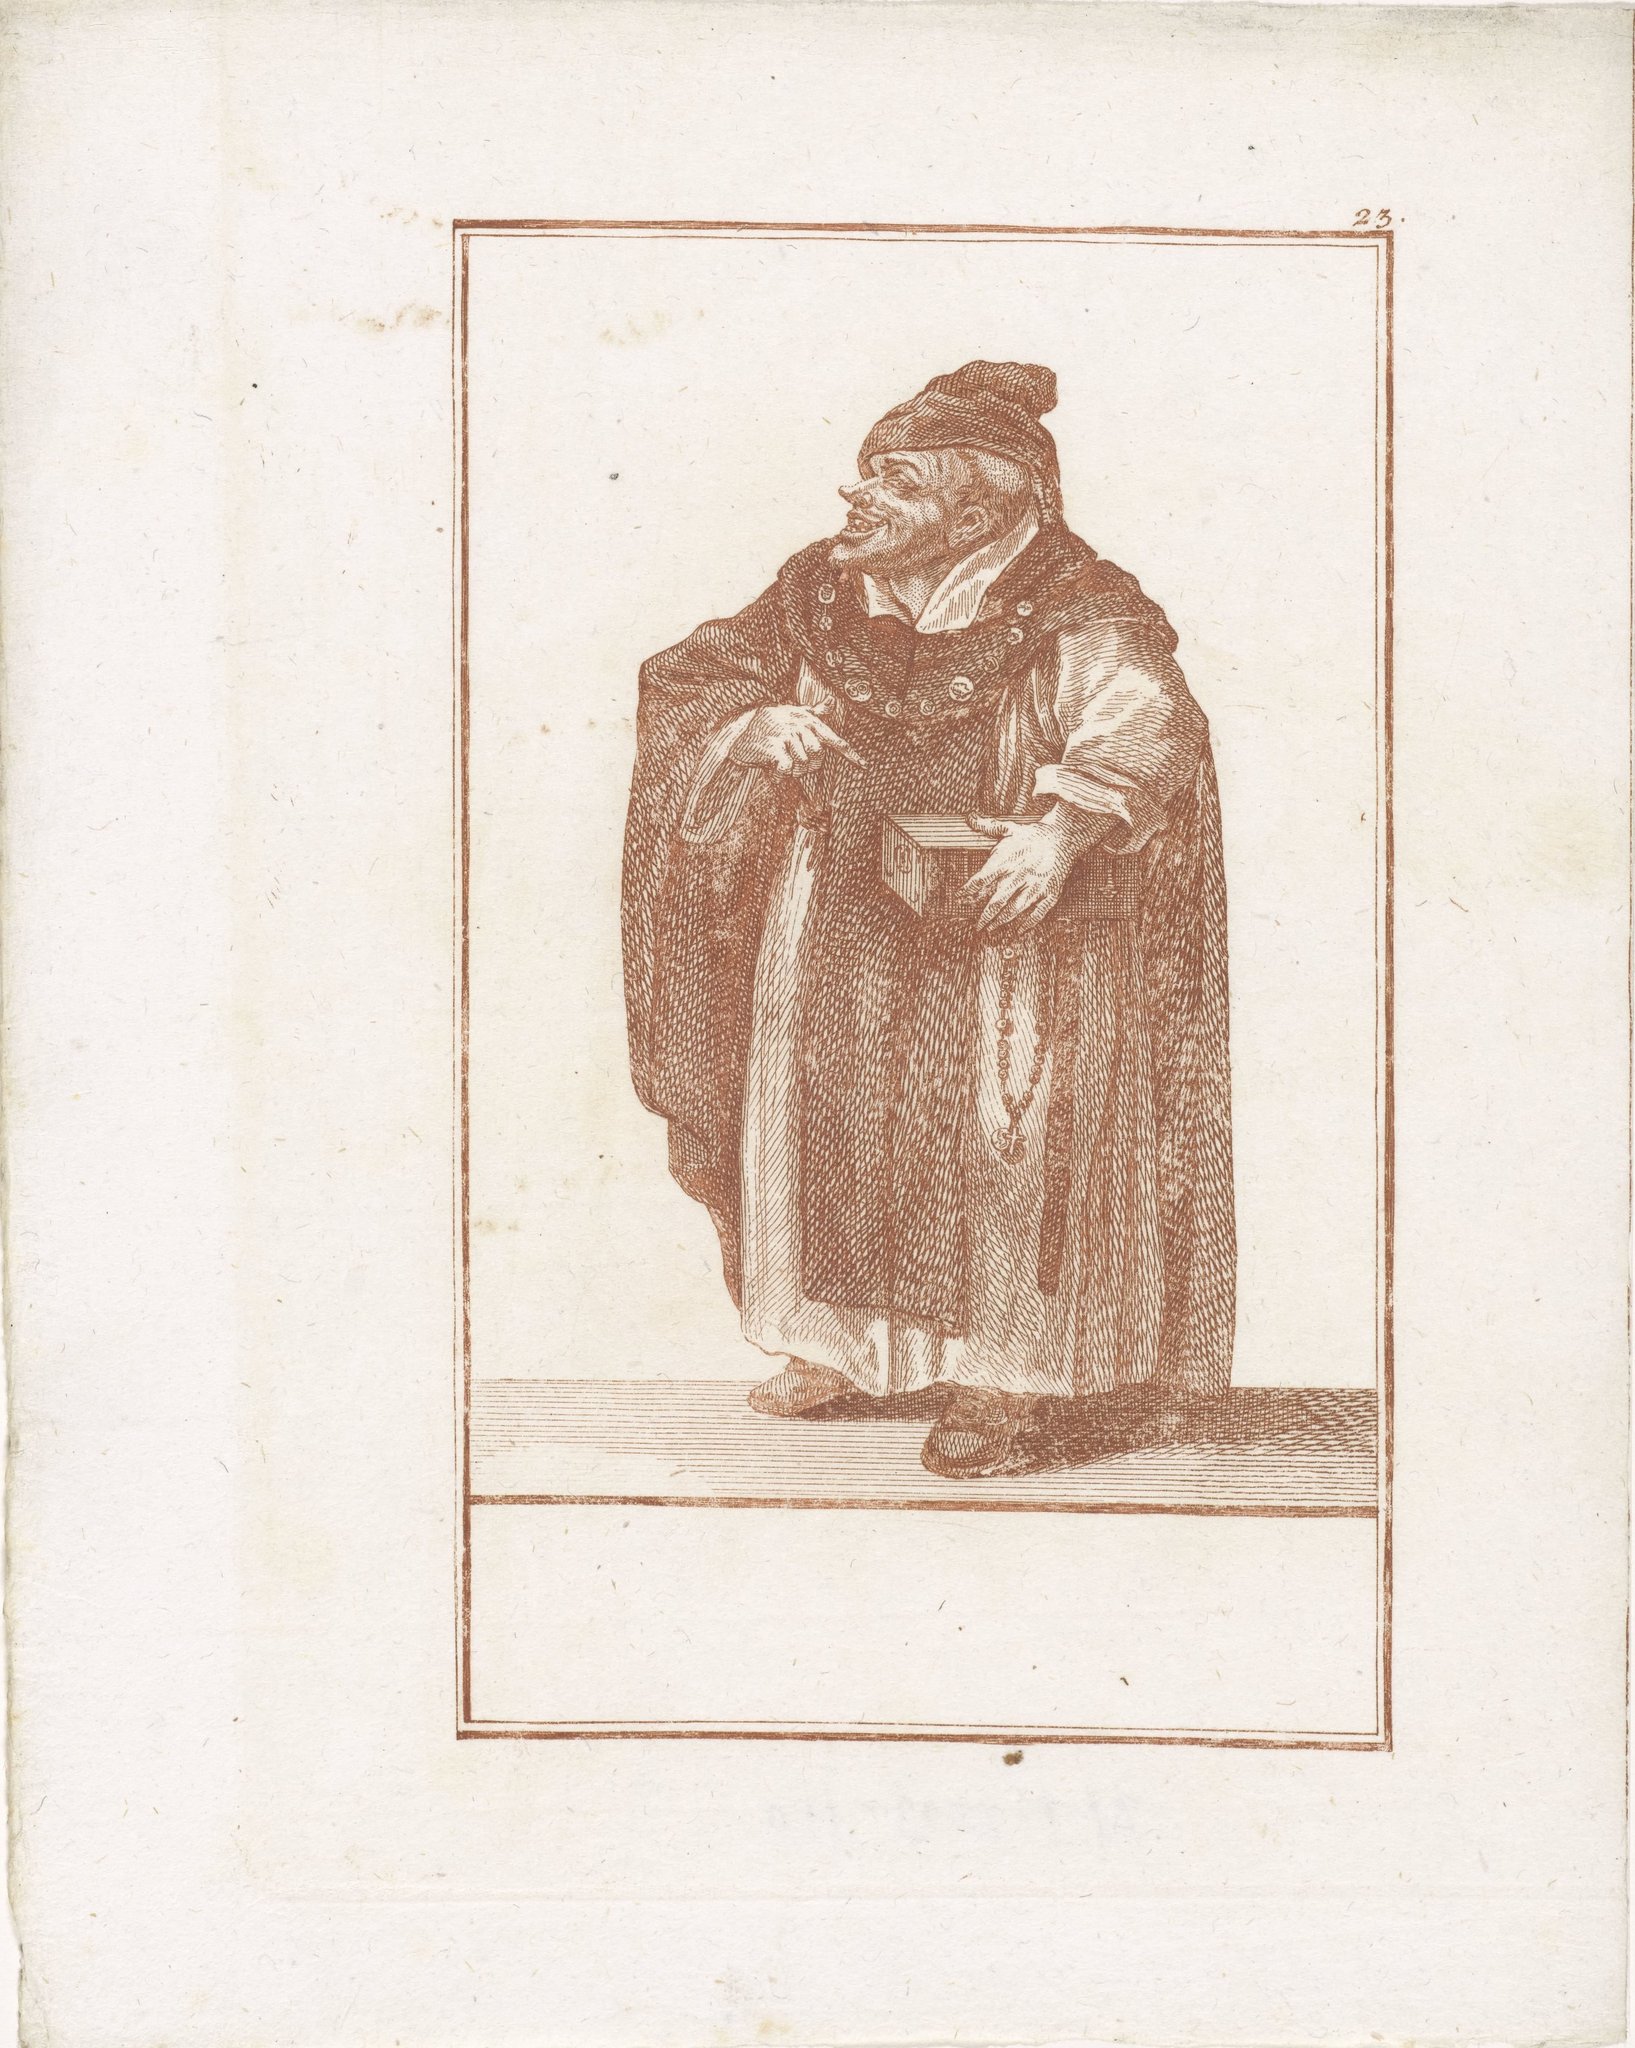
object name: cartoon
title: Misbruiken van de katholieke geestelijkheid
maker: jacob gole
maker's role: print maker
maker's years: 1660-1724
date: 1724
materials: paper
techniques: etching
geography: amsterdam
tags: mouth wide open, teeth pressed together, aids for prayer, e.g. rosary, monk(s), friar(s), (aspects of) christian religion or the church (as institution) ridiculed, criticized, or caricaturized, money-chest, treasure-chest, money-box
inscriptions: collector's mark: Lugt 2228, collector's mark: Lugt 2760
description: Grijnzende monnik met een geldkist onder zijn linkerarm, waarnaar hij wijst met zijn rechterhand. Om zijn nek een ketting van munten. Langs zijn zijde een rozenkrans. De prent is deel van een 50-delige serie met als onderwerp de misbruiken van de katholieke geestelijkheid.